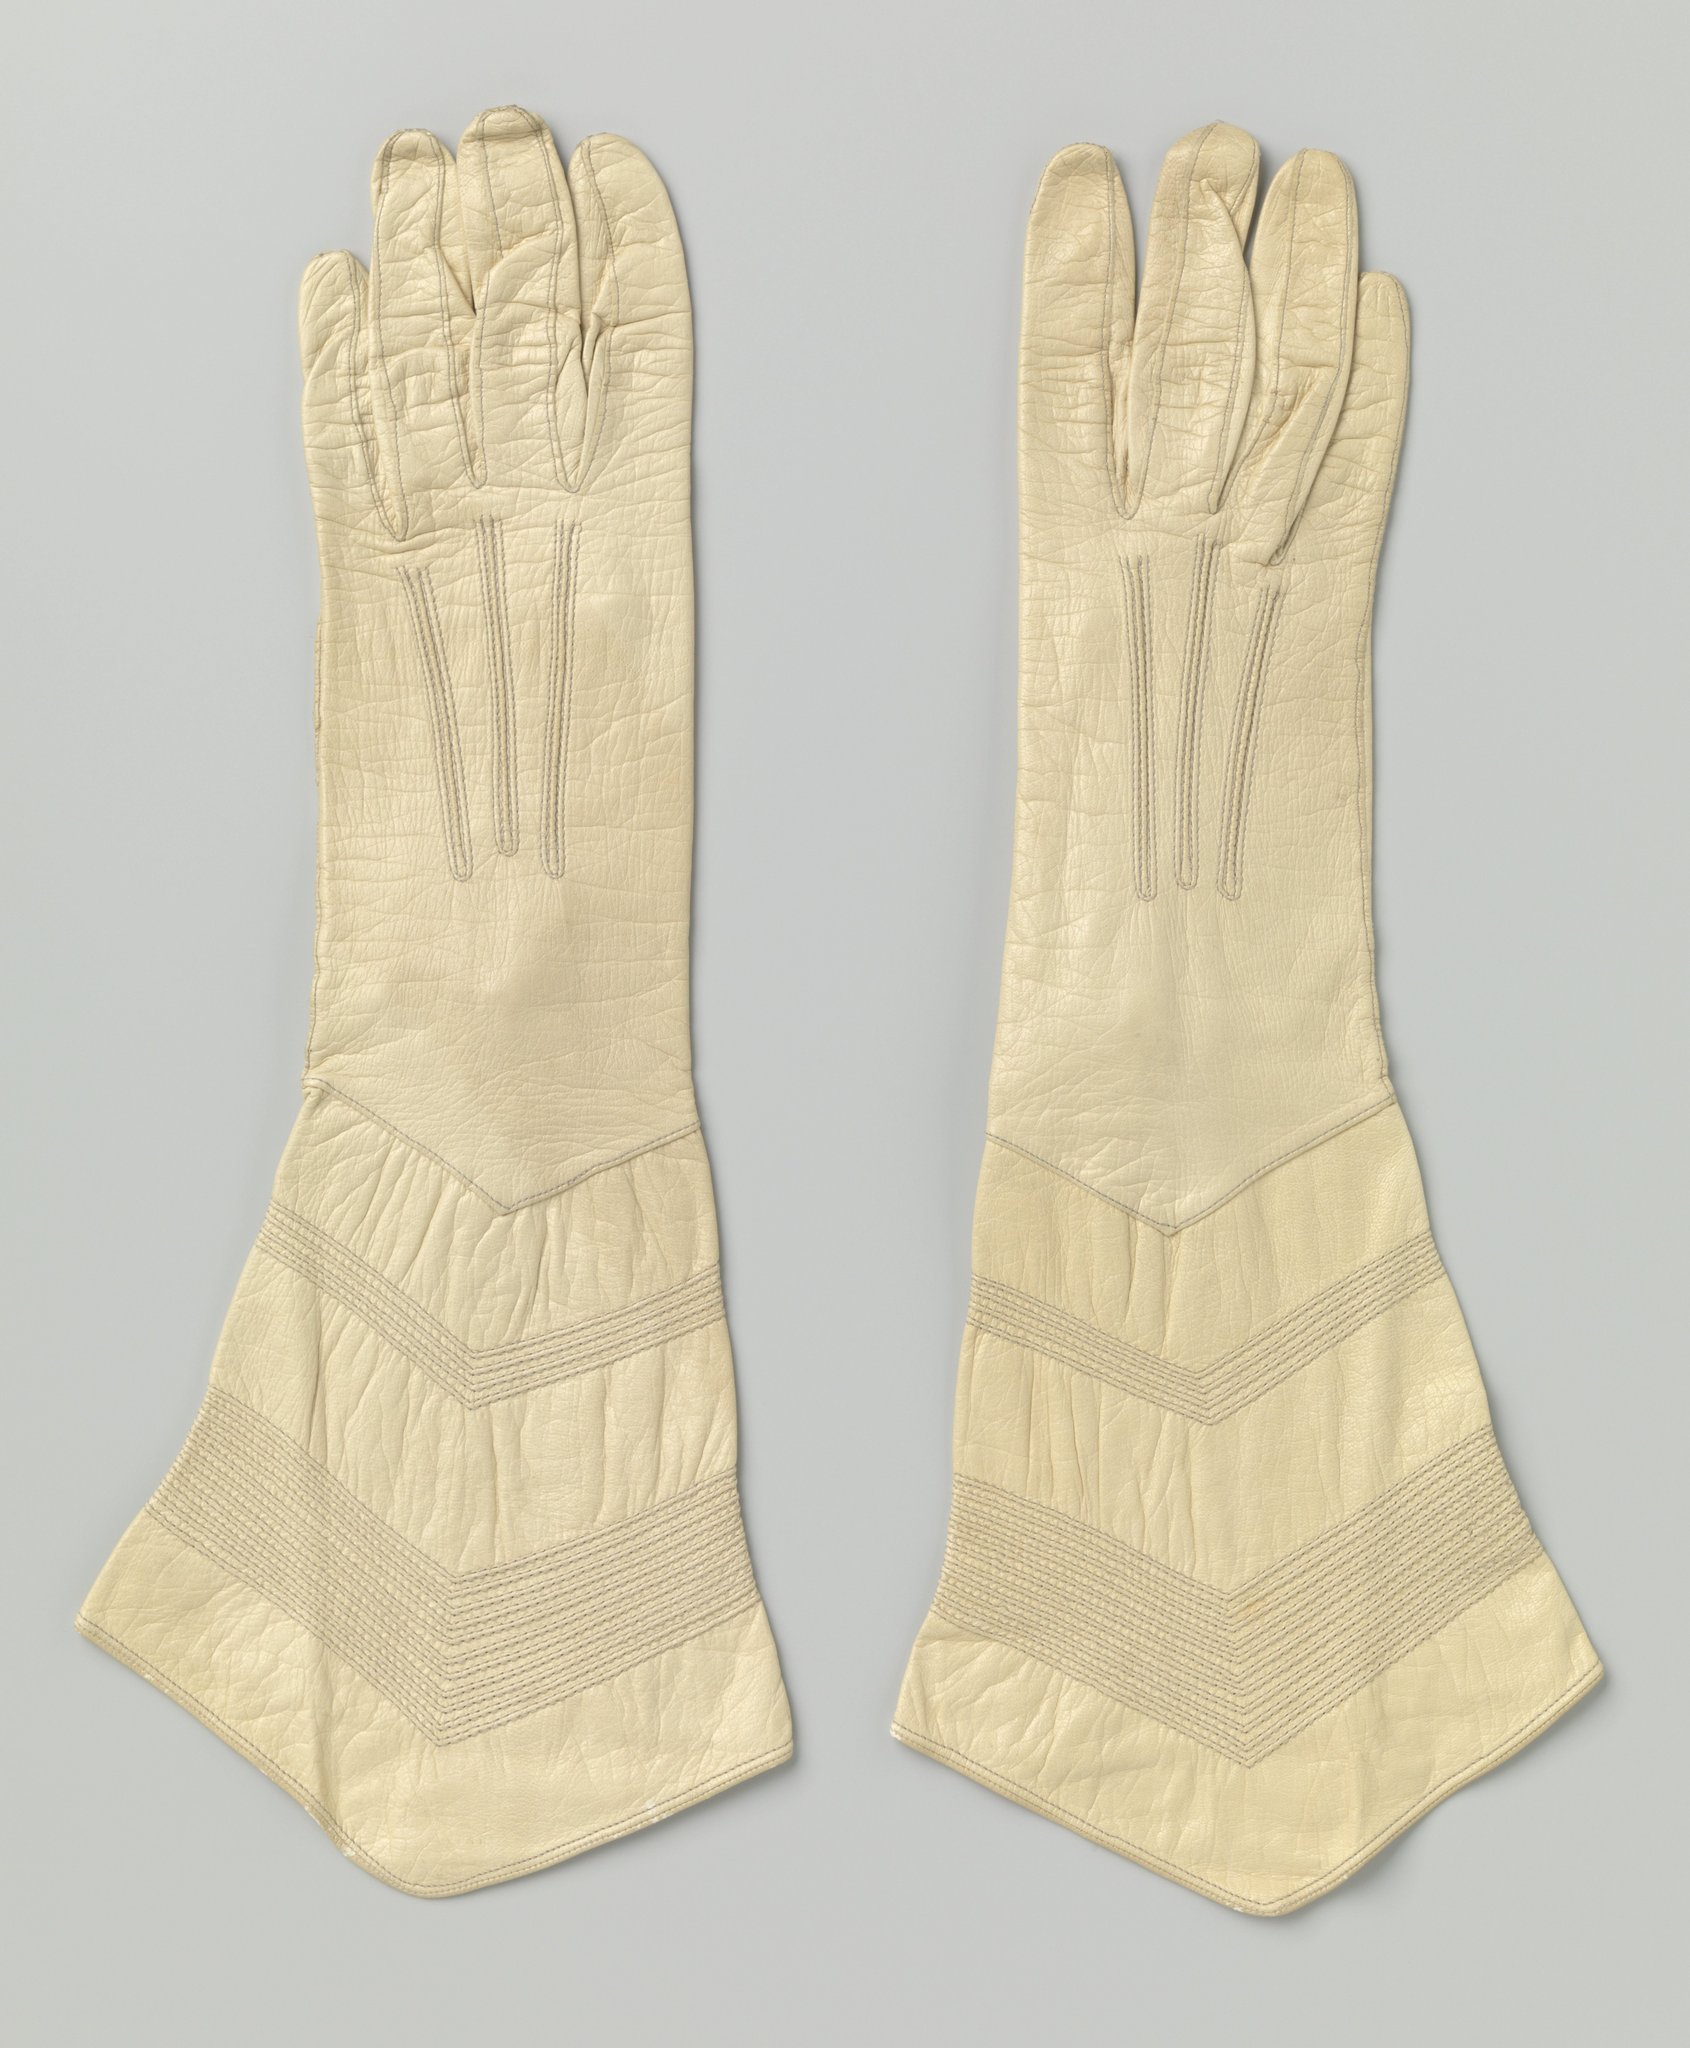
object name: clothing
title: Pair of gloves with pointed cuffs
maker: m. laimböck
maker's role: modehuis, modewarenhuis, modewinkel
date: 1922-1930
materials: leather, mother of pearl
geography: amsterdam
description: Linkerhandschoen van beige glacé-leer. Model: driekwartlang met kappen en middensplitten. Naden van de kappen in diepe punten gevormd en doorgestikt. Dikke parel als sluiting. Adres: binnenin gedrukt: 1. BILTON/V.S.PAT.SEPT.19.'22(?). 2. Gekroonde adelaar met banderol waarop M. LAIMBOCK/UITTYROL/AMSTERDAM/K.HOFLEVERANCIER (onduidelijk) en: MADE IN SAXONY. Saksen, voor fa. Laimböck Amsterdam. 1922-1930 (?).